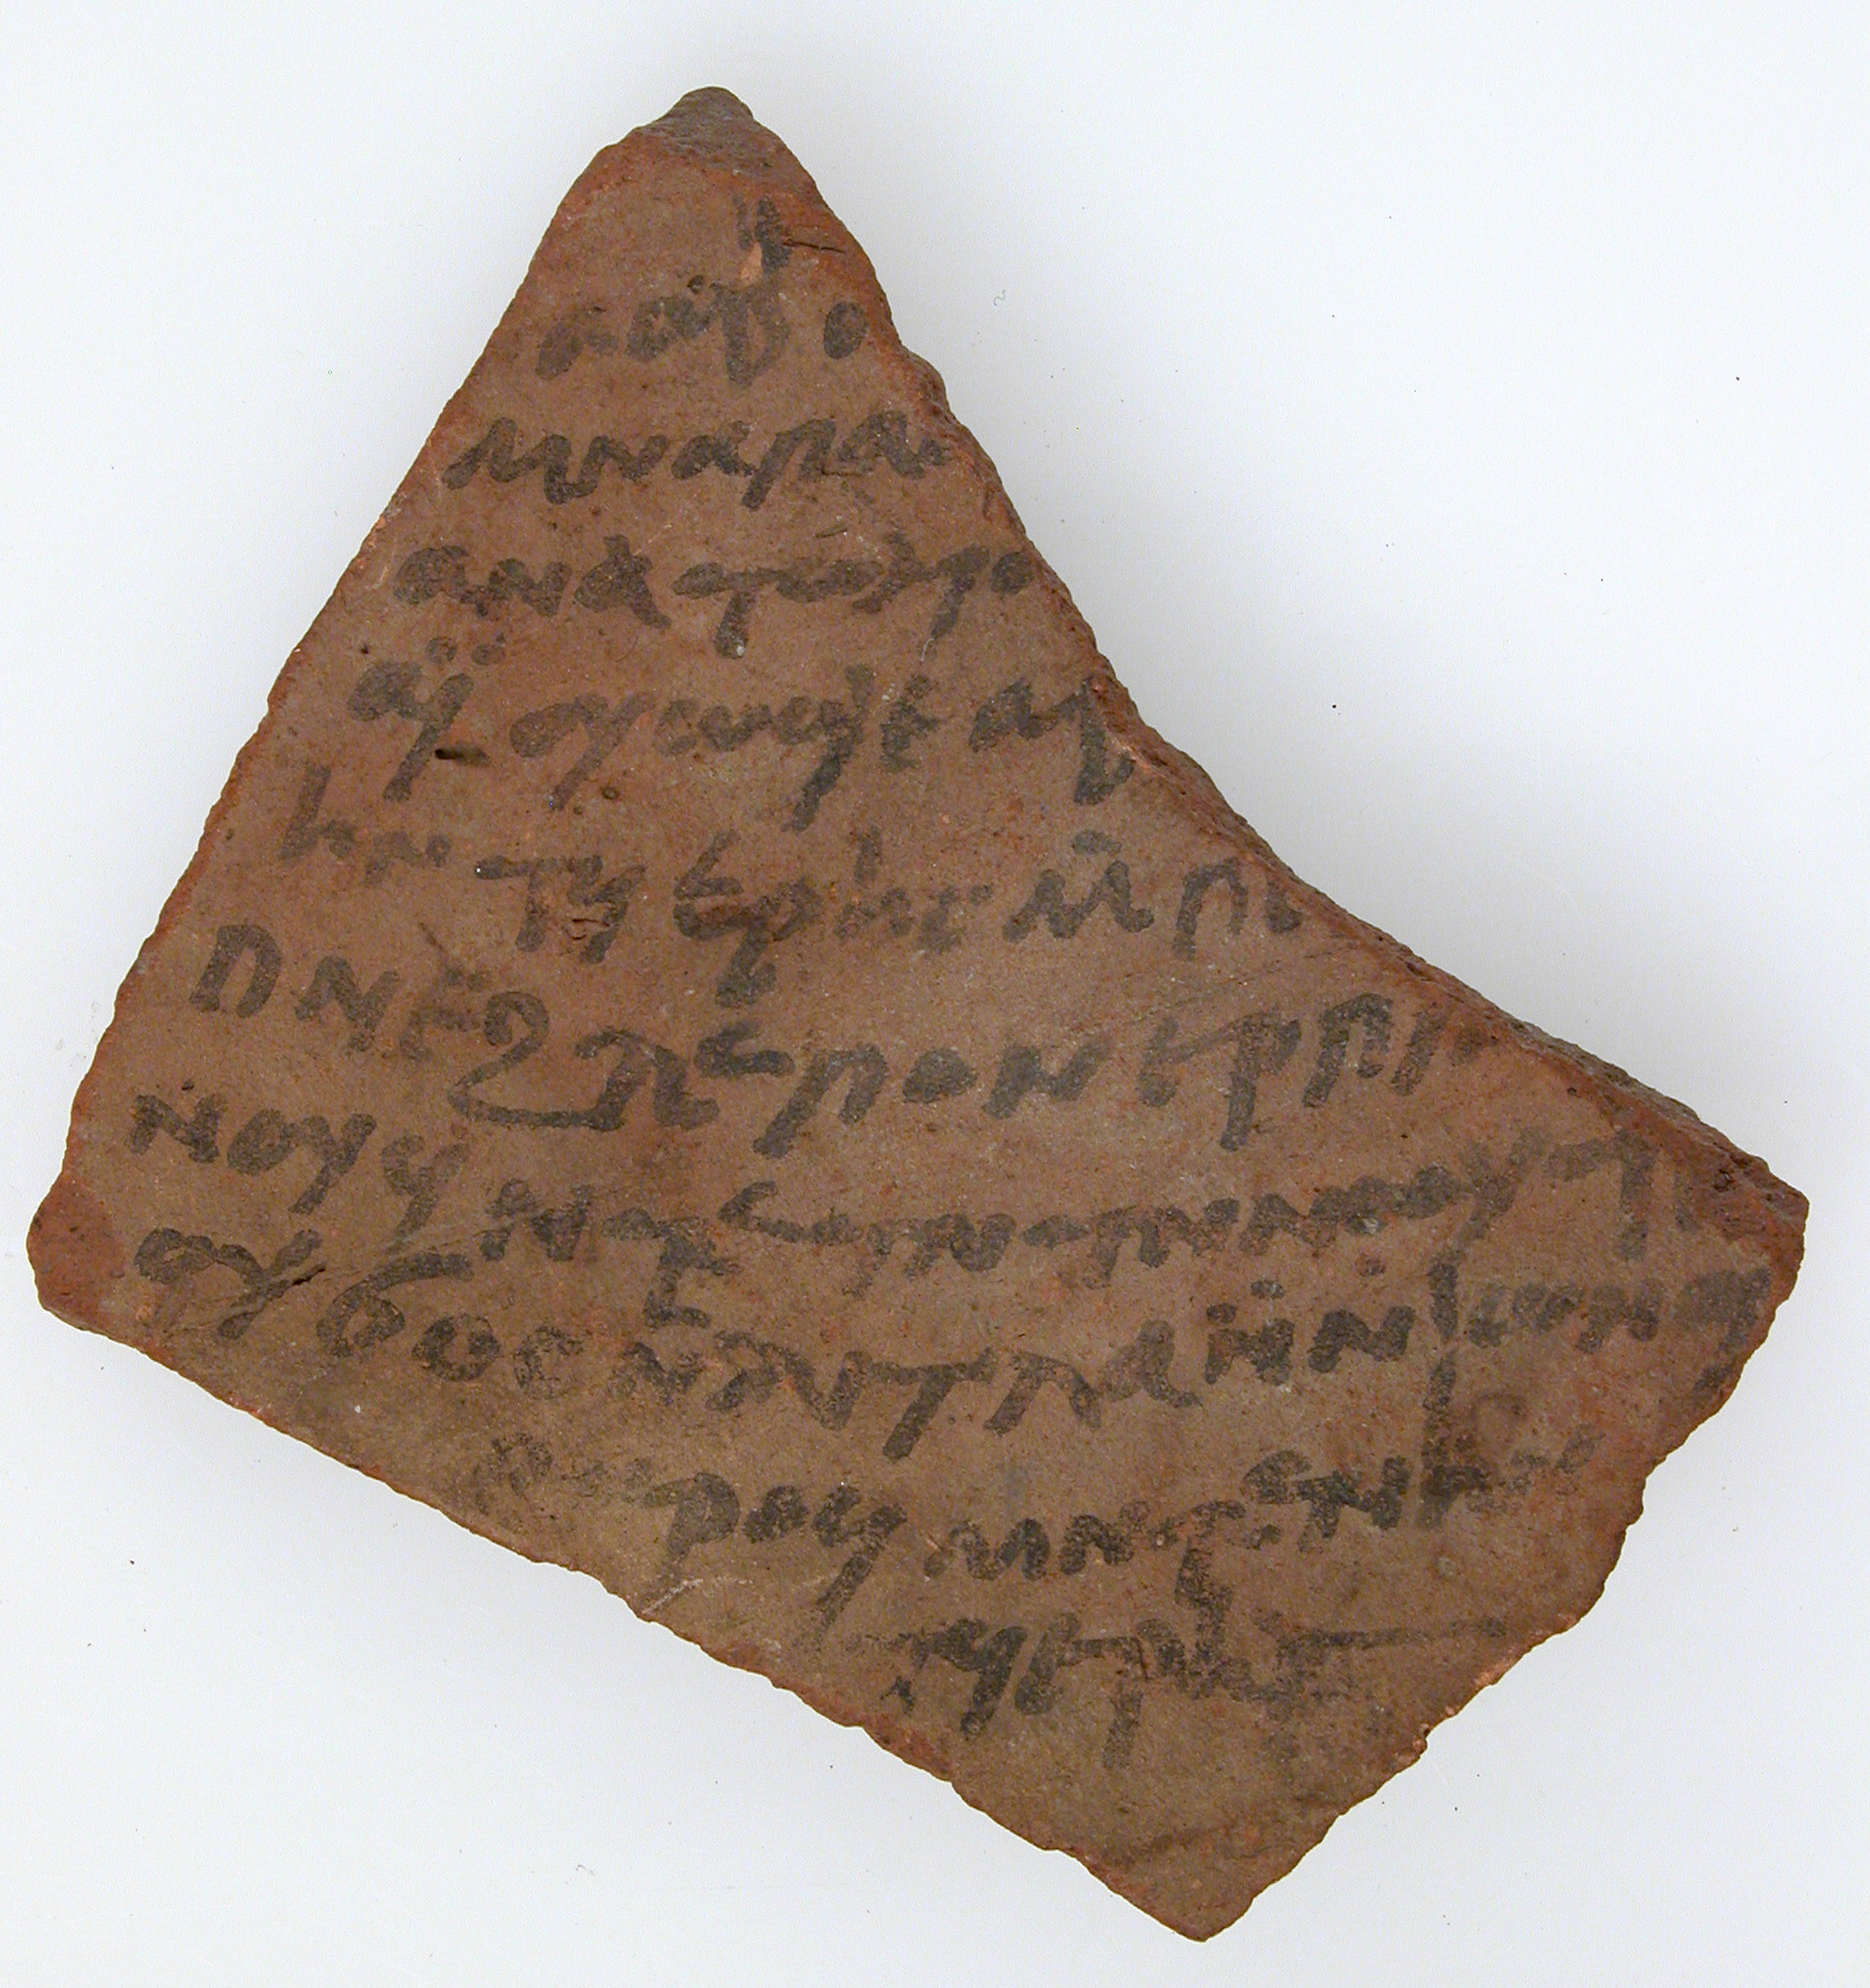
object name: ostrakon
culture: coptic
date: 601-700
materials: ink, pottery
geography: egypt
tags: coptic,documents